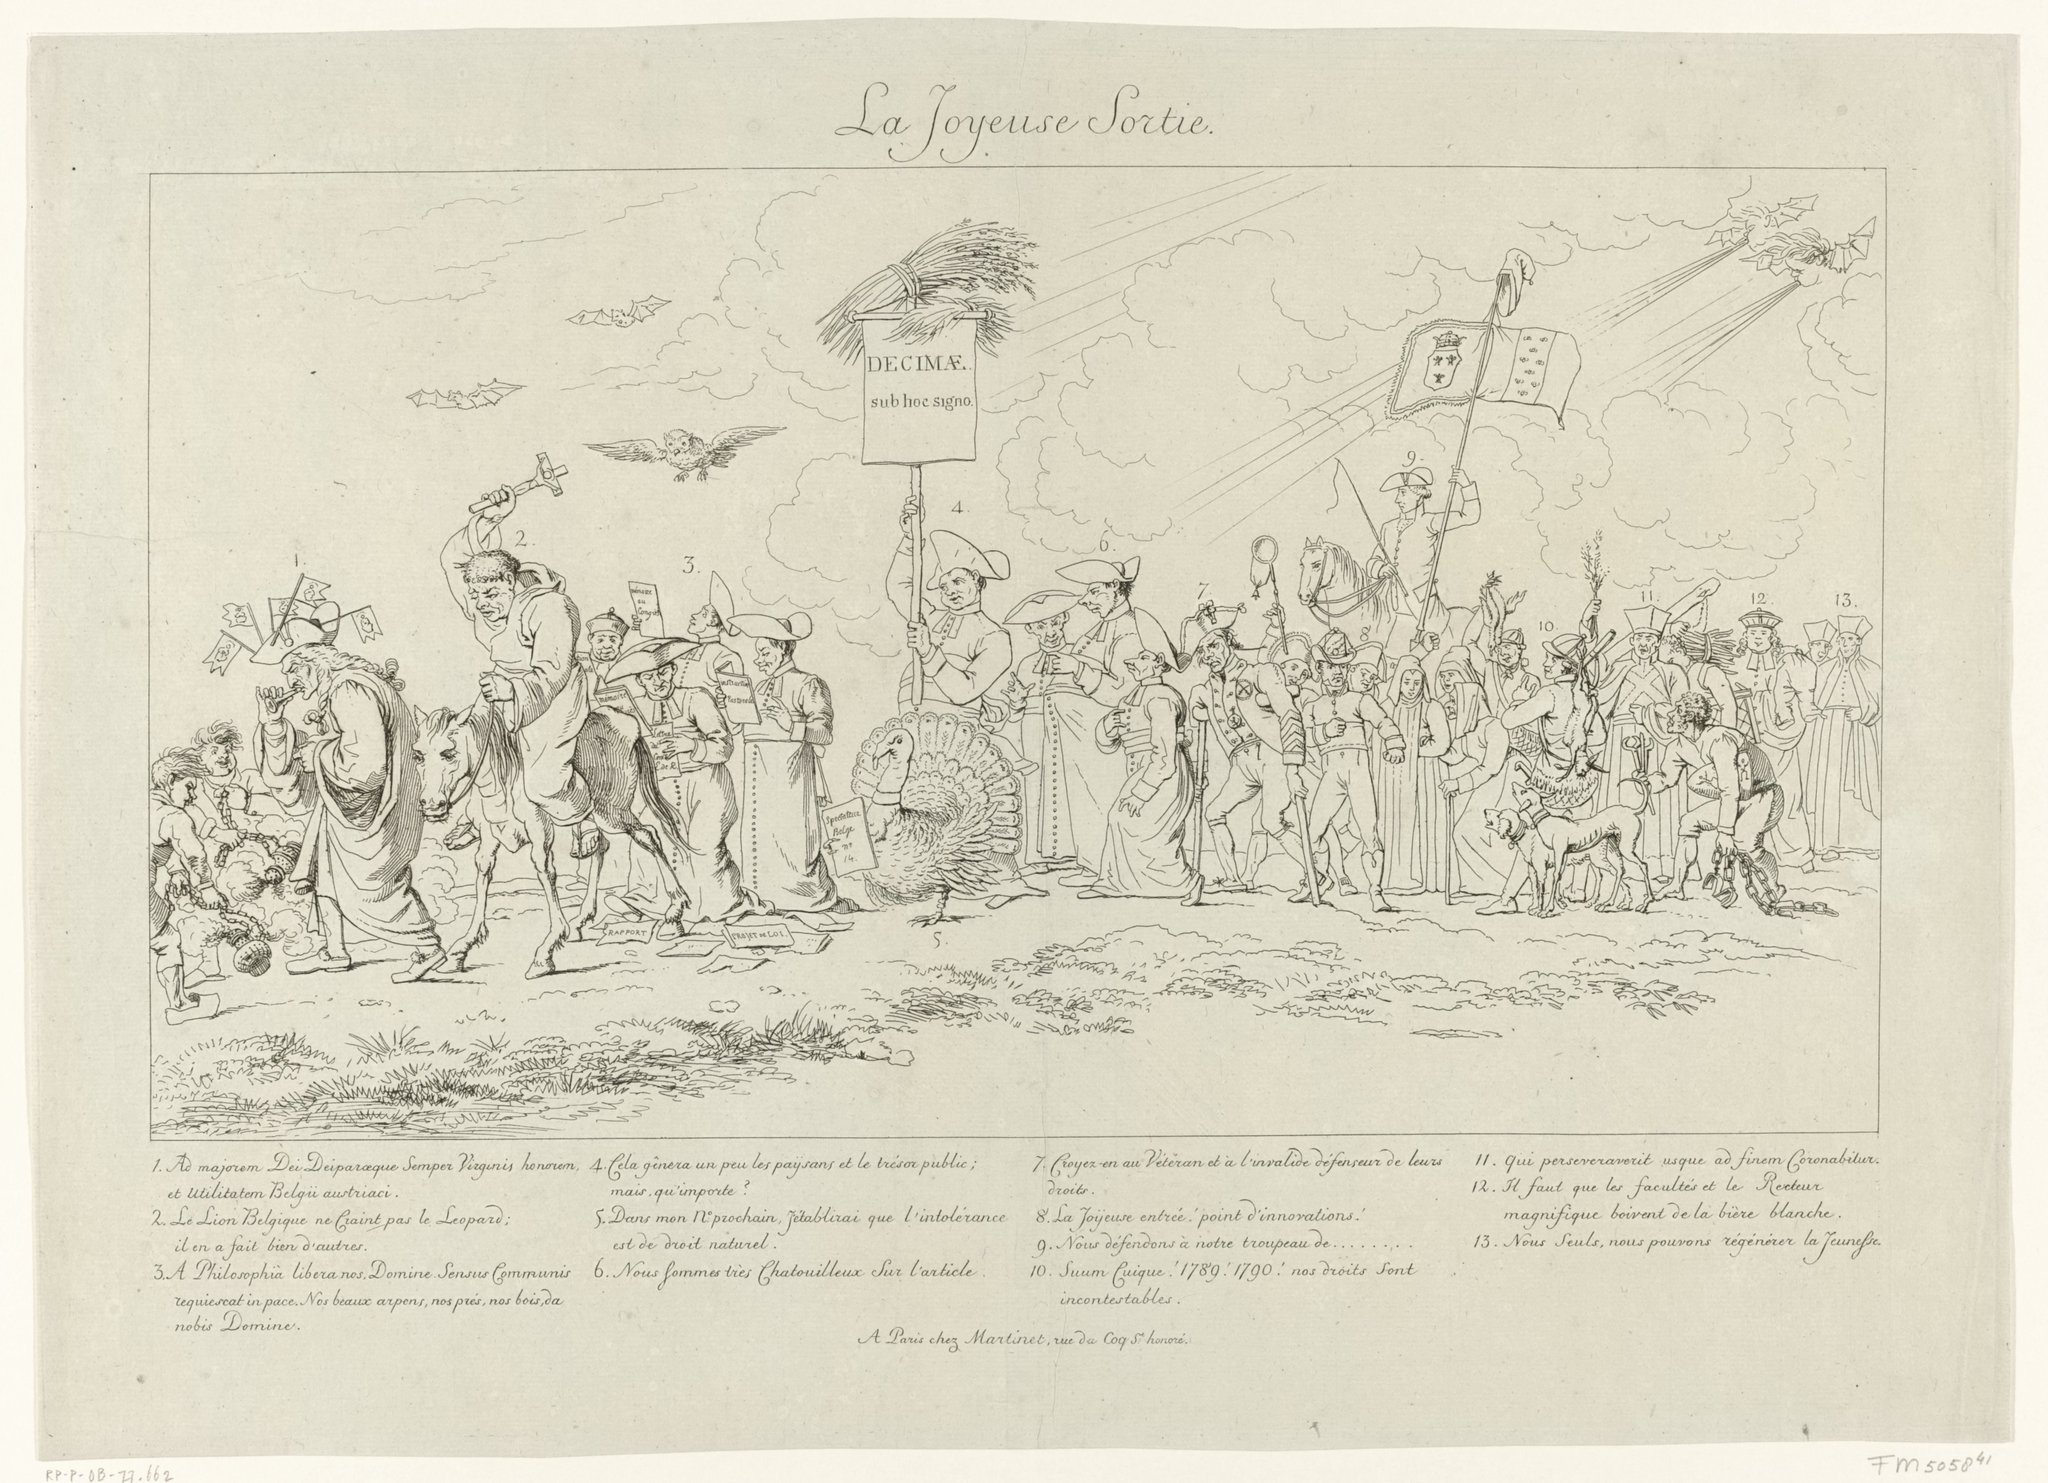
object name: cartoon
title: Brabantse Omwenteling, 1787-1790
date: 1787-1790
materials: paper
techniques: etching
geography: southern netherlands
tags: retreat of the defeated, brabant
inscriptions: collector's mark: Lugt 2228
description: Spotprent op het uit elkaar vallen van de Verenigde Nederlandse Staten door gewapend Pruisisch ingrijpen in 1790. In een lange stoet vertrekken de karikaturale aanvoerders en aanhangers van de Brabantse Omwenteling. In de stoet onder andere geestelijken, een kalkoen, oorlogsveteraan, jagers en een smit met boeien. Met legenda 1-13 in het Frans. Onderdeel van een grote groep van prenten betrekking hebbend op de gebeurtenissen van de Brabantse Omwenteling en de periode 1787-1790.